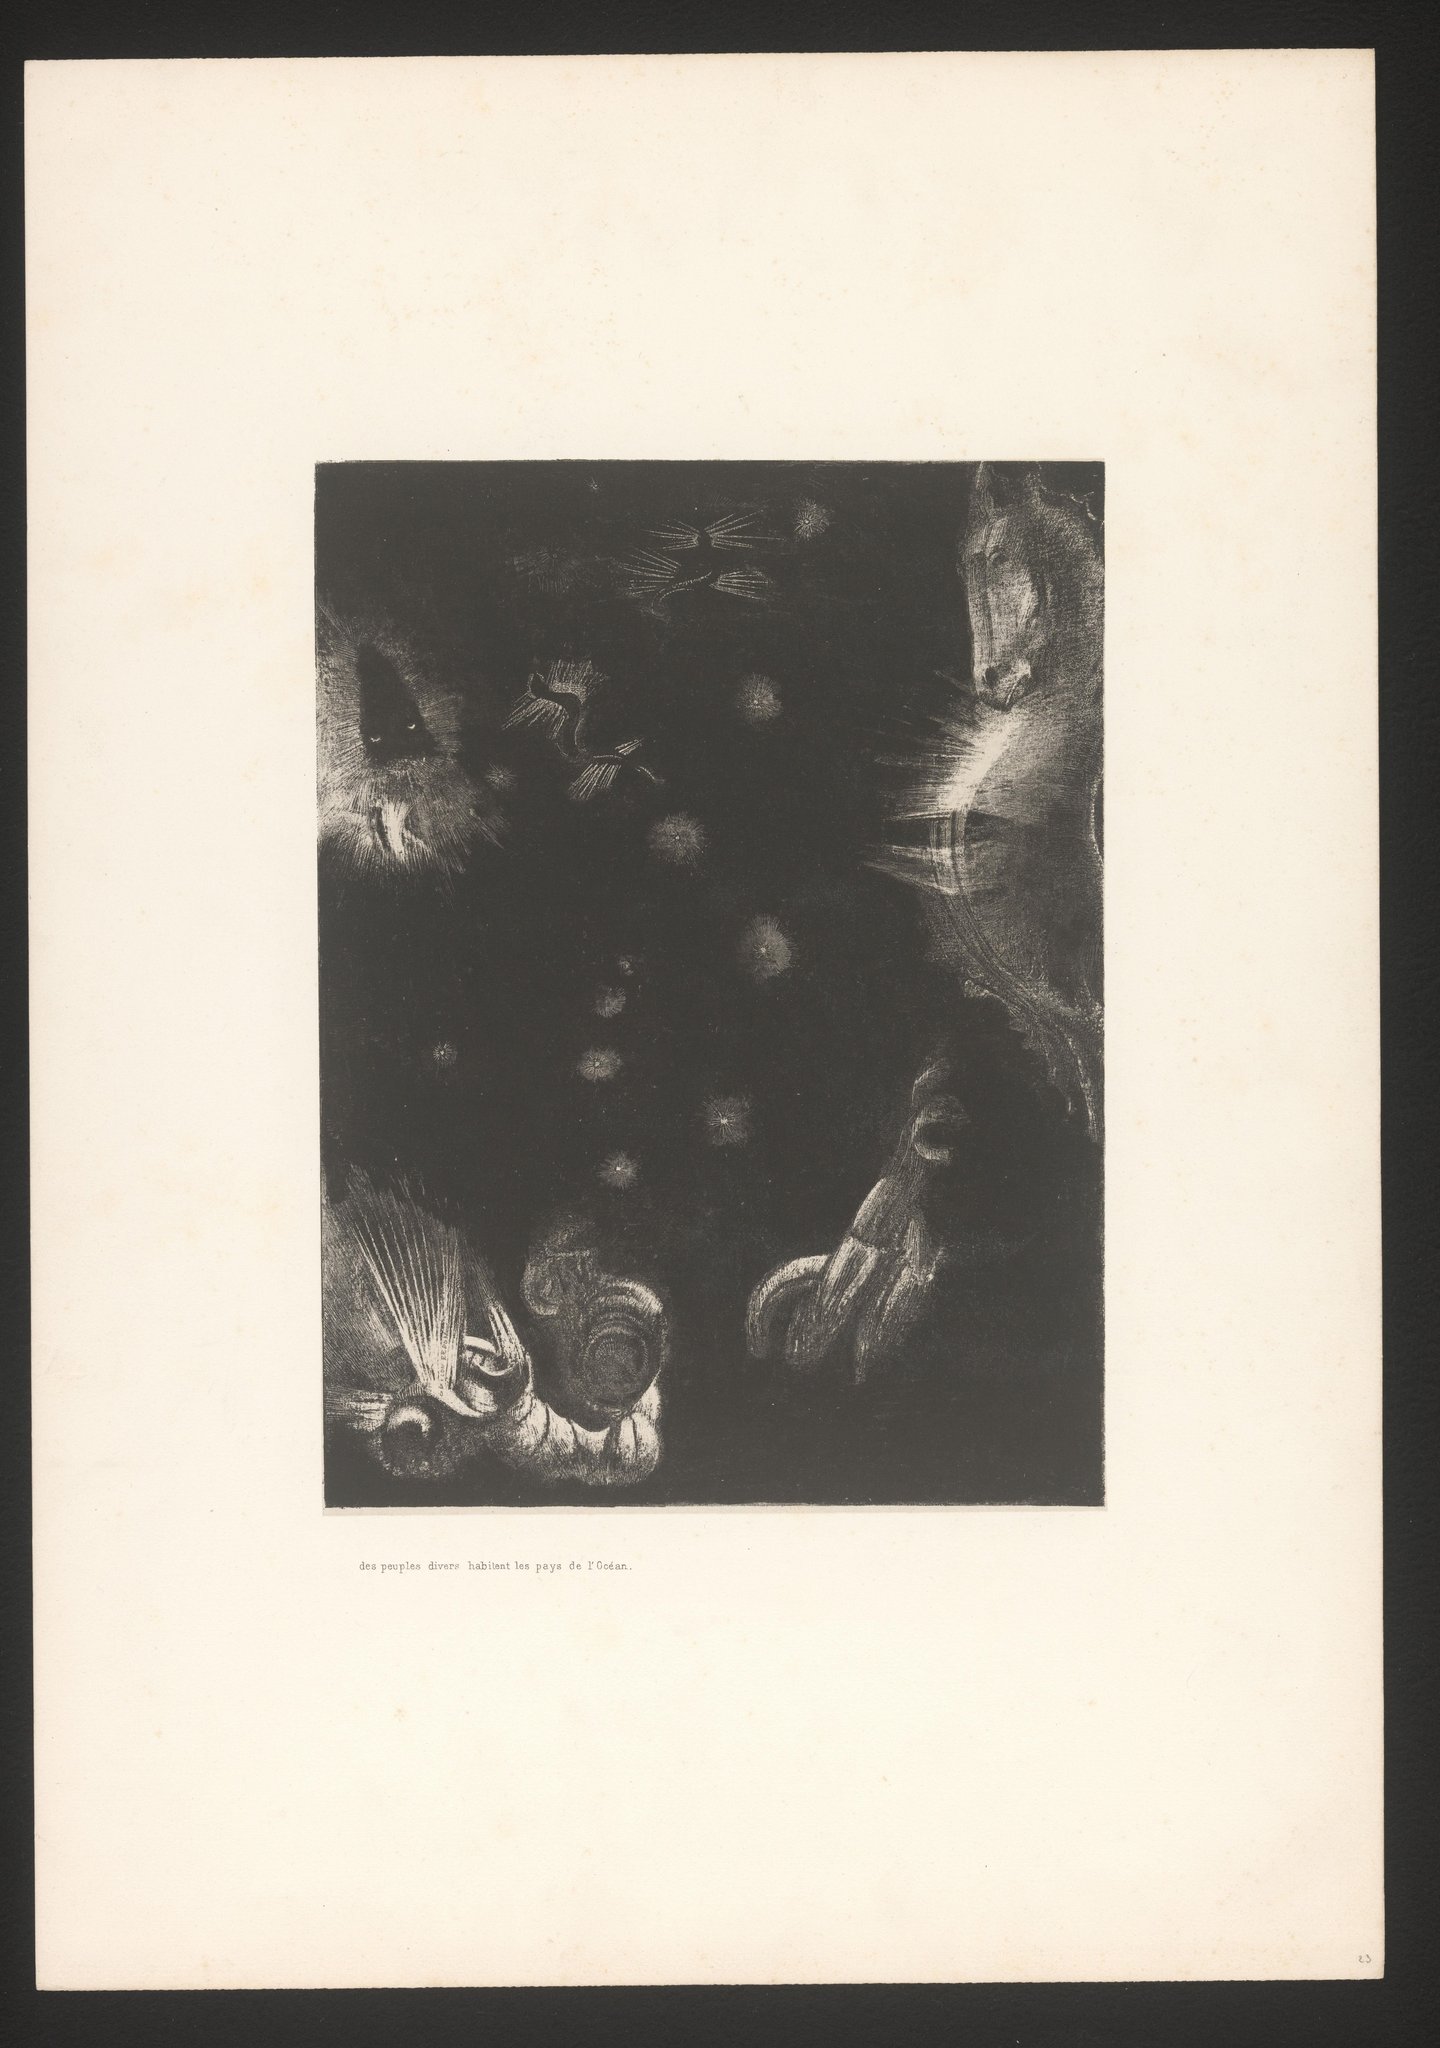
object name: print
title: Verzoeking van de H. Antonius, derde serie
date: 1896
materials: paper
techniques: lithograph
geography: paris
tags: sea-horse, hippocamp, 'hippocampus', (horse/fish) (mythological hybrid monster), deep-sea fishes